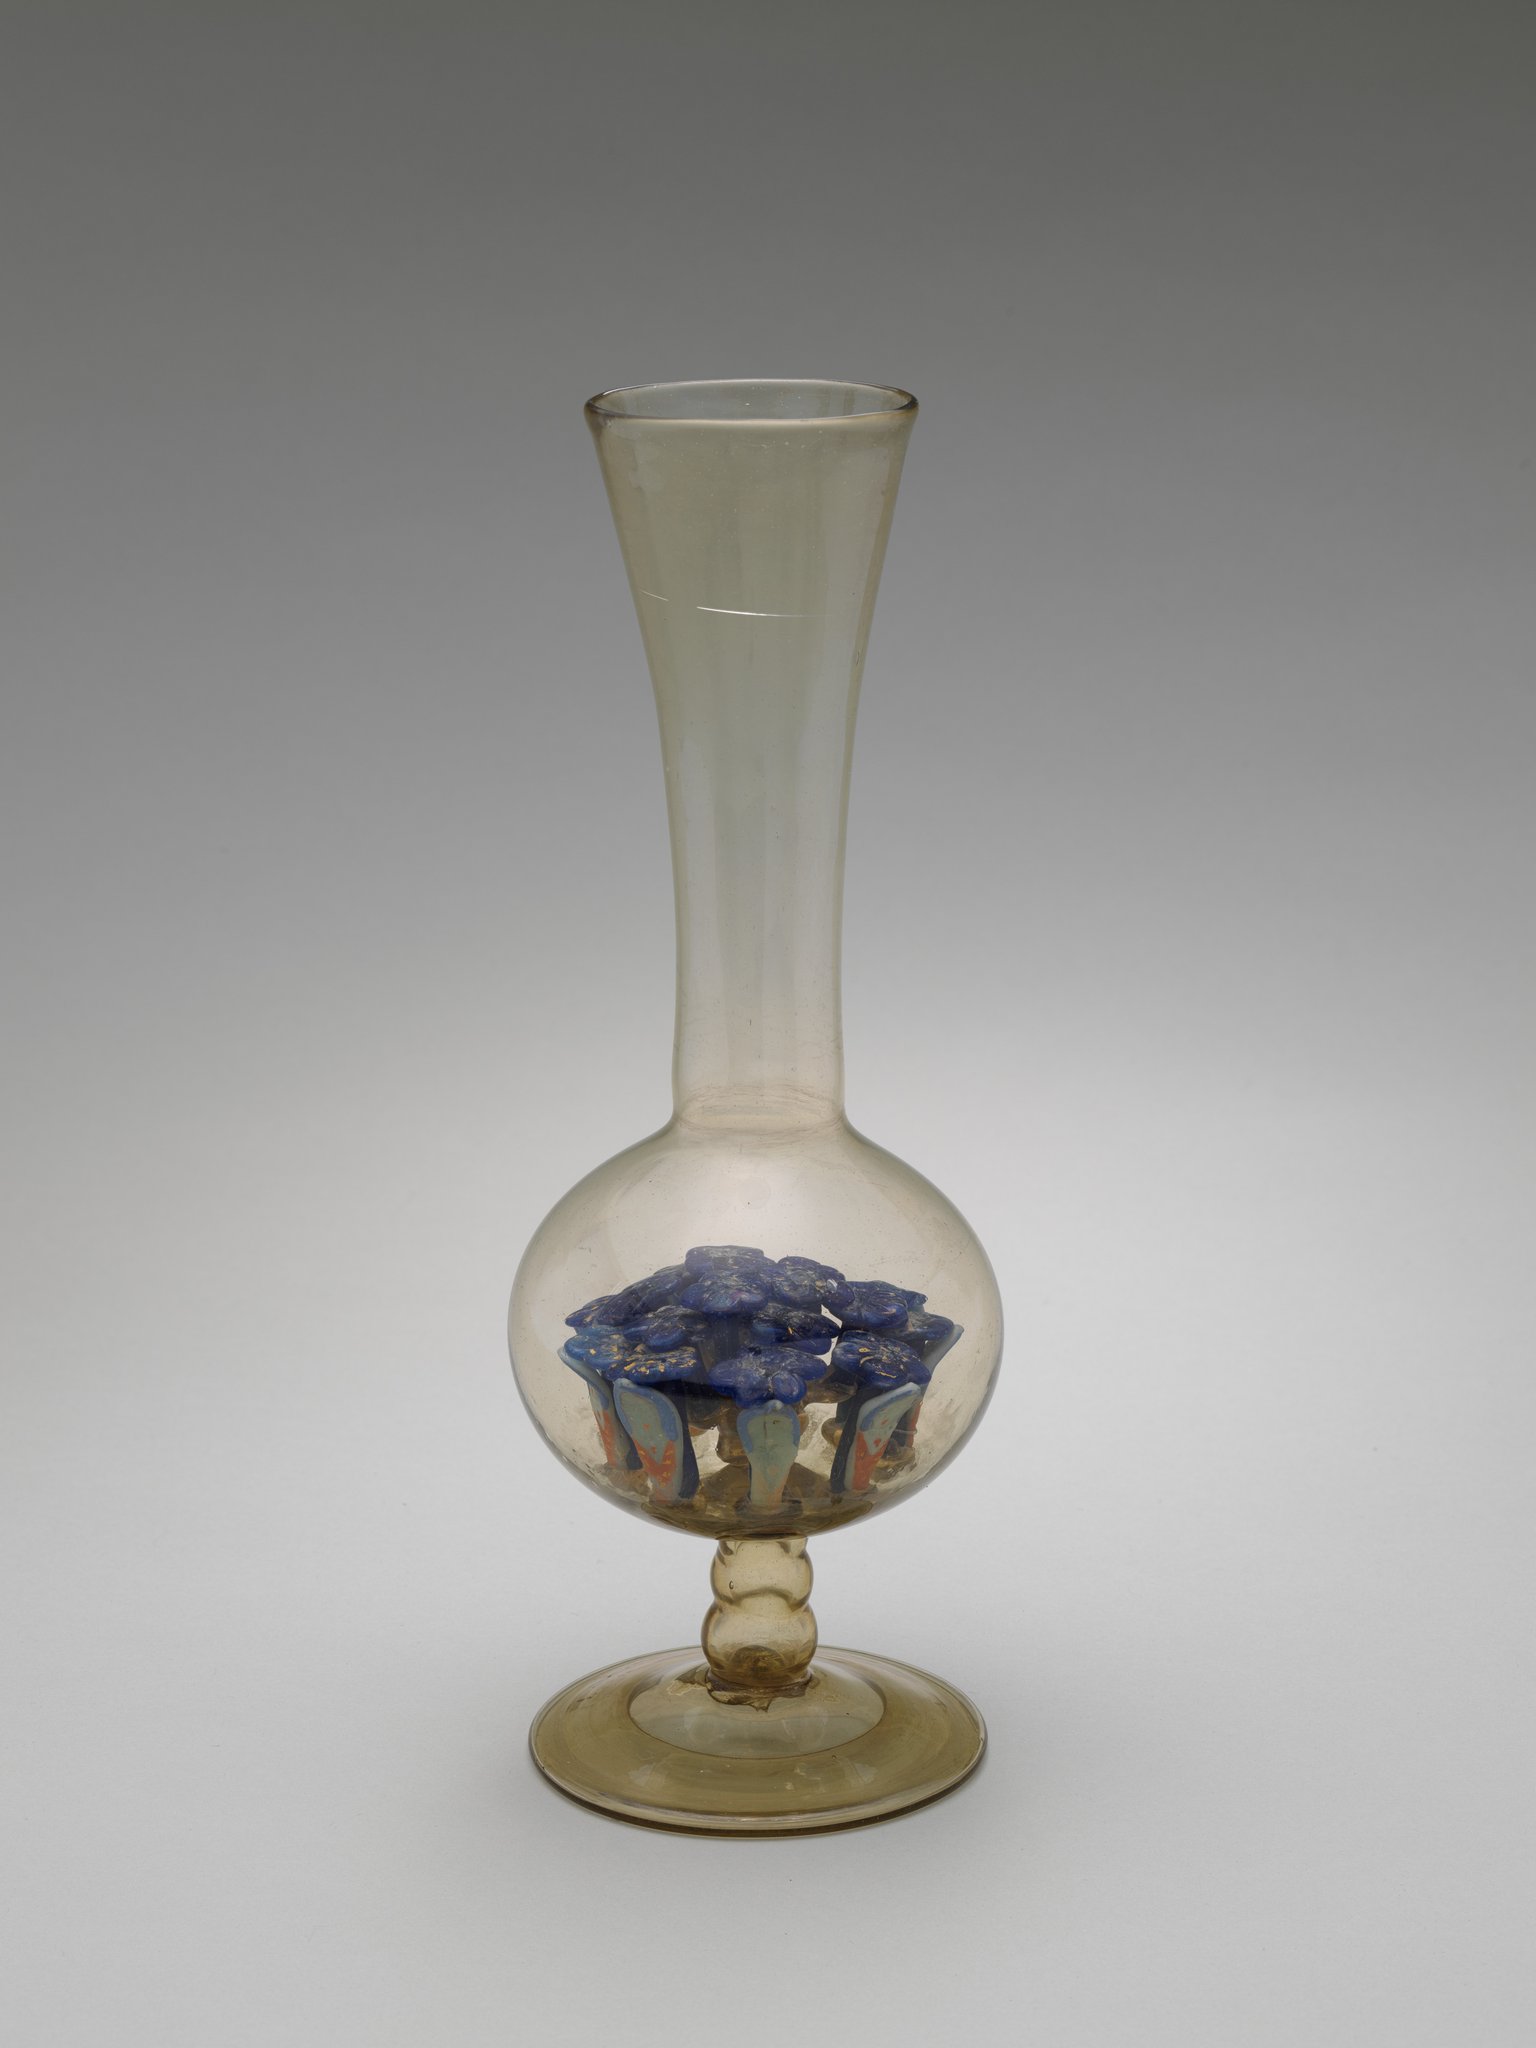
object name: vase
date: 1701-1900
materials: glass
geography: iran